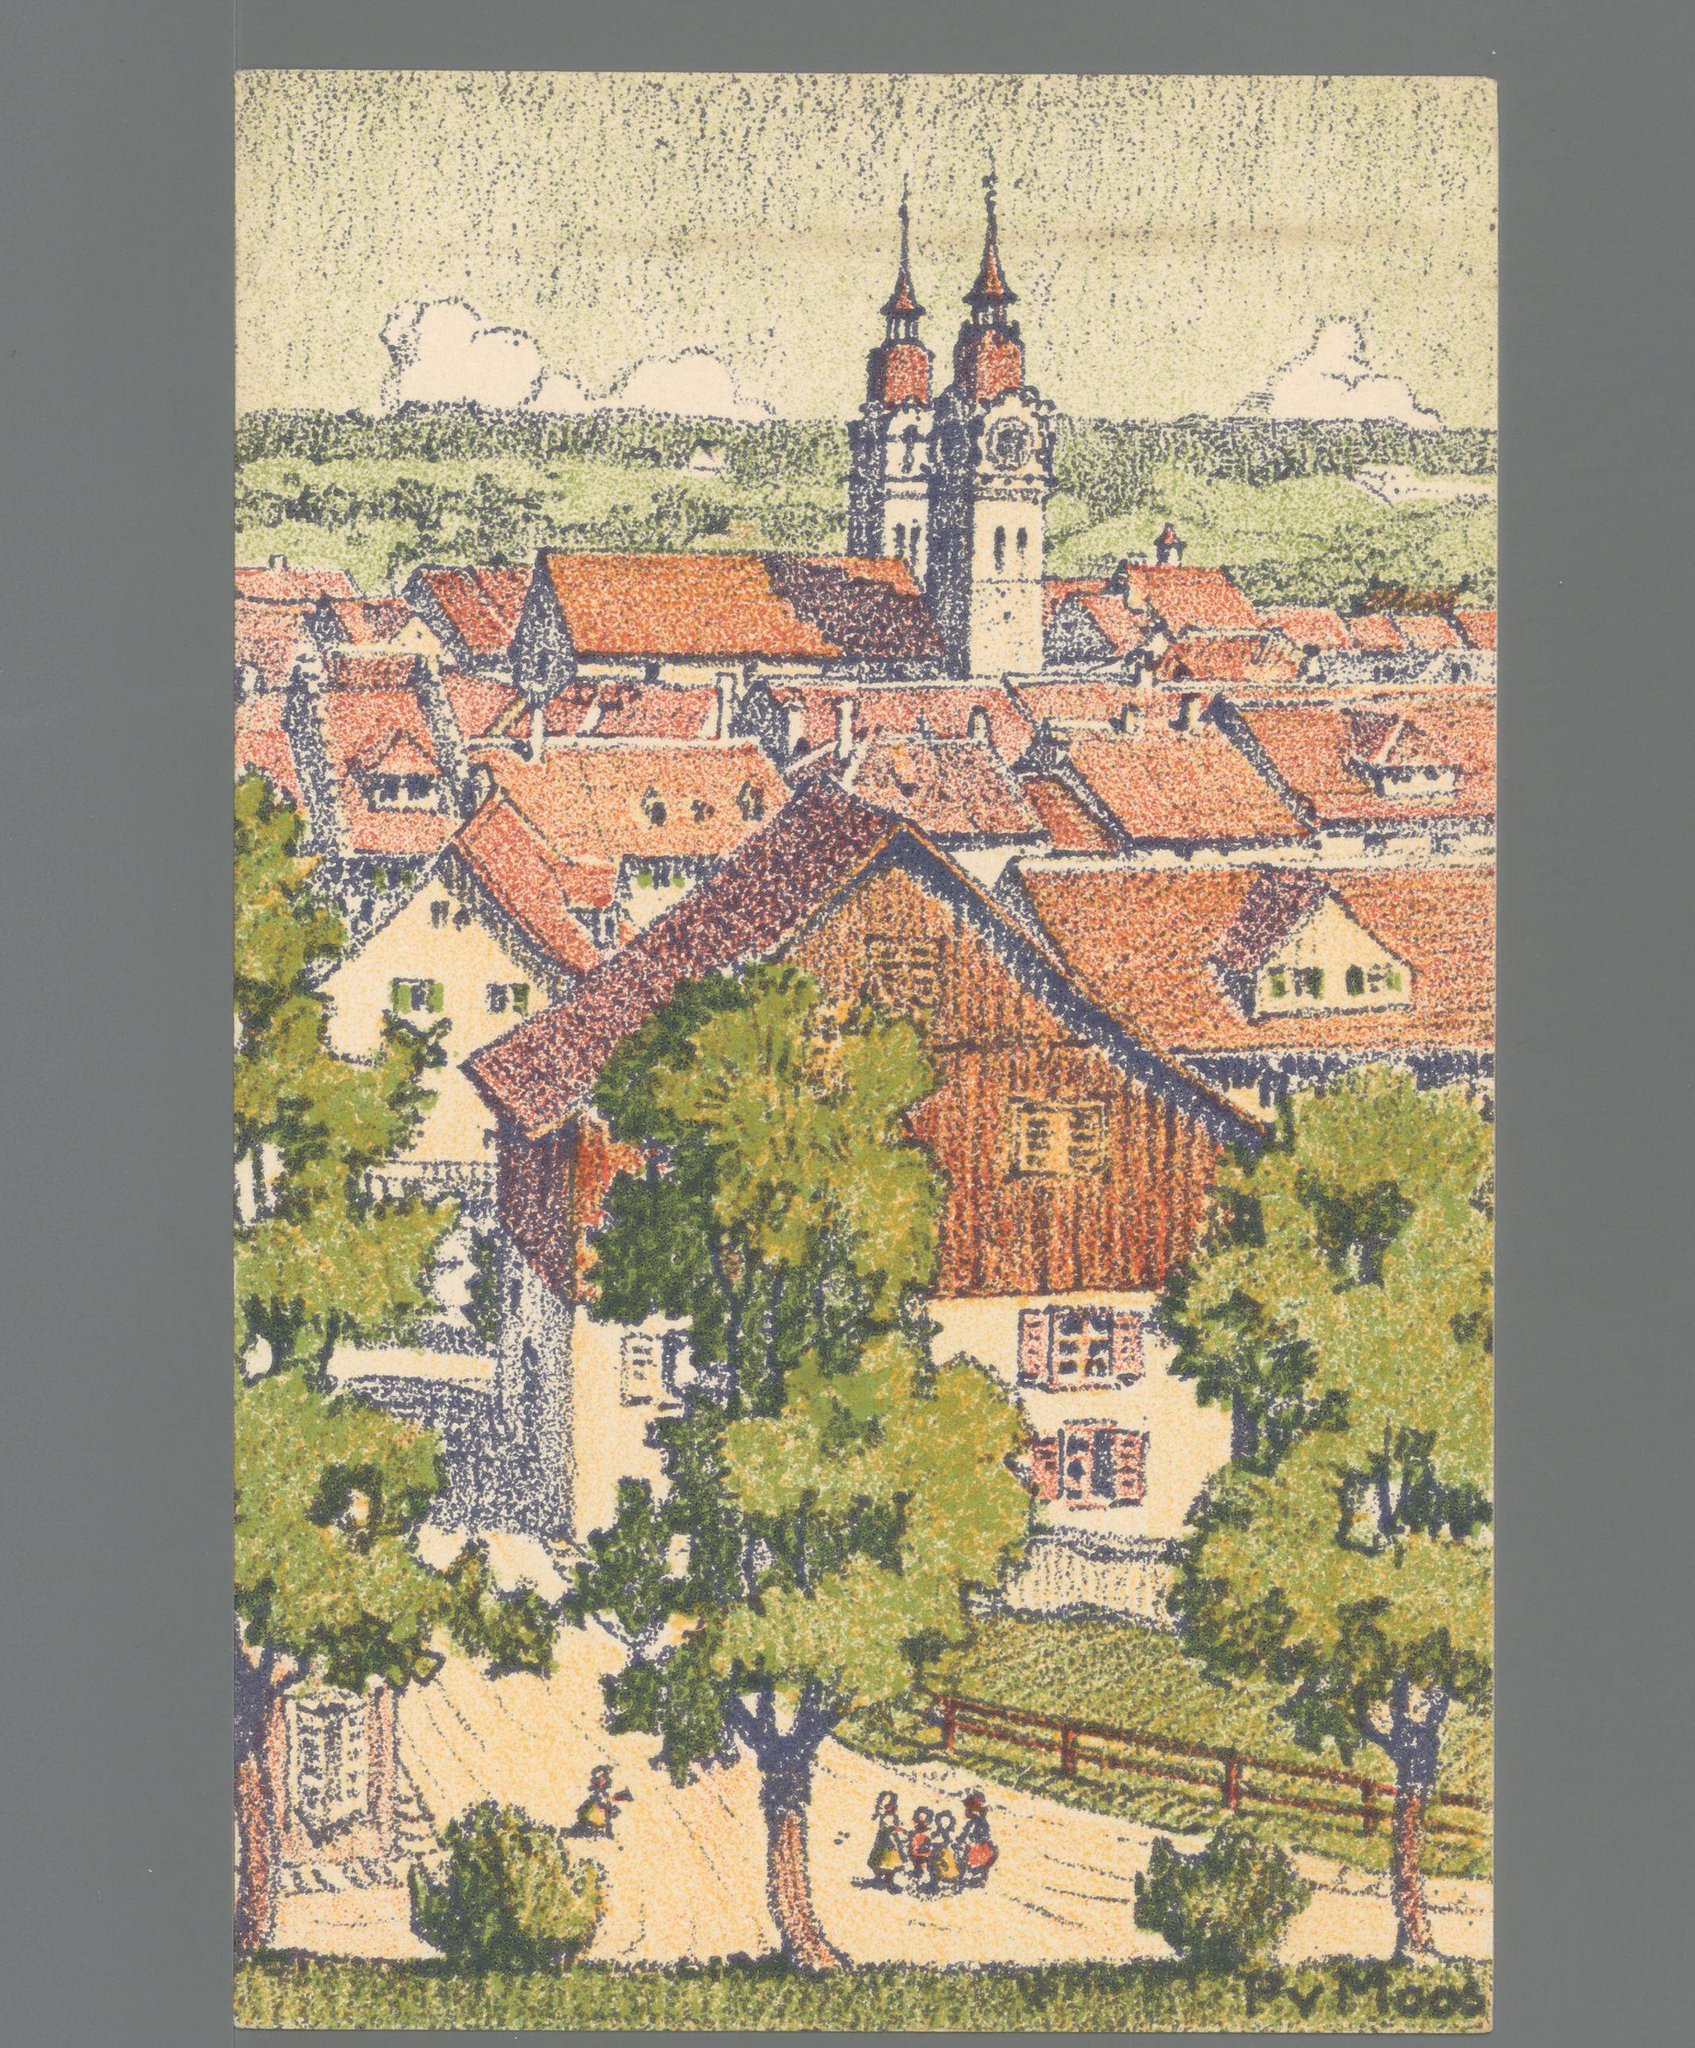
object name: print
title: Winterthur v. der Hochwacht aus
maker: p. von moos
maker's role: print maker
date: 1905-1913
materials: cardboard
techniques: lithograph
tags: church (exterior), city-view, and landscape with man-made constructions (+ city(-scape) with figures, staffage)